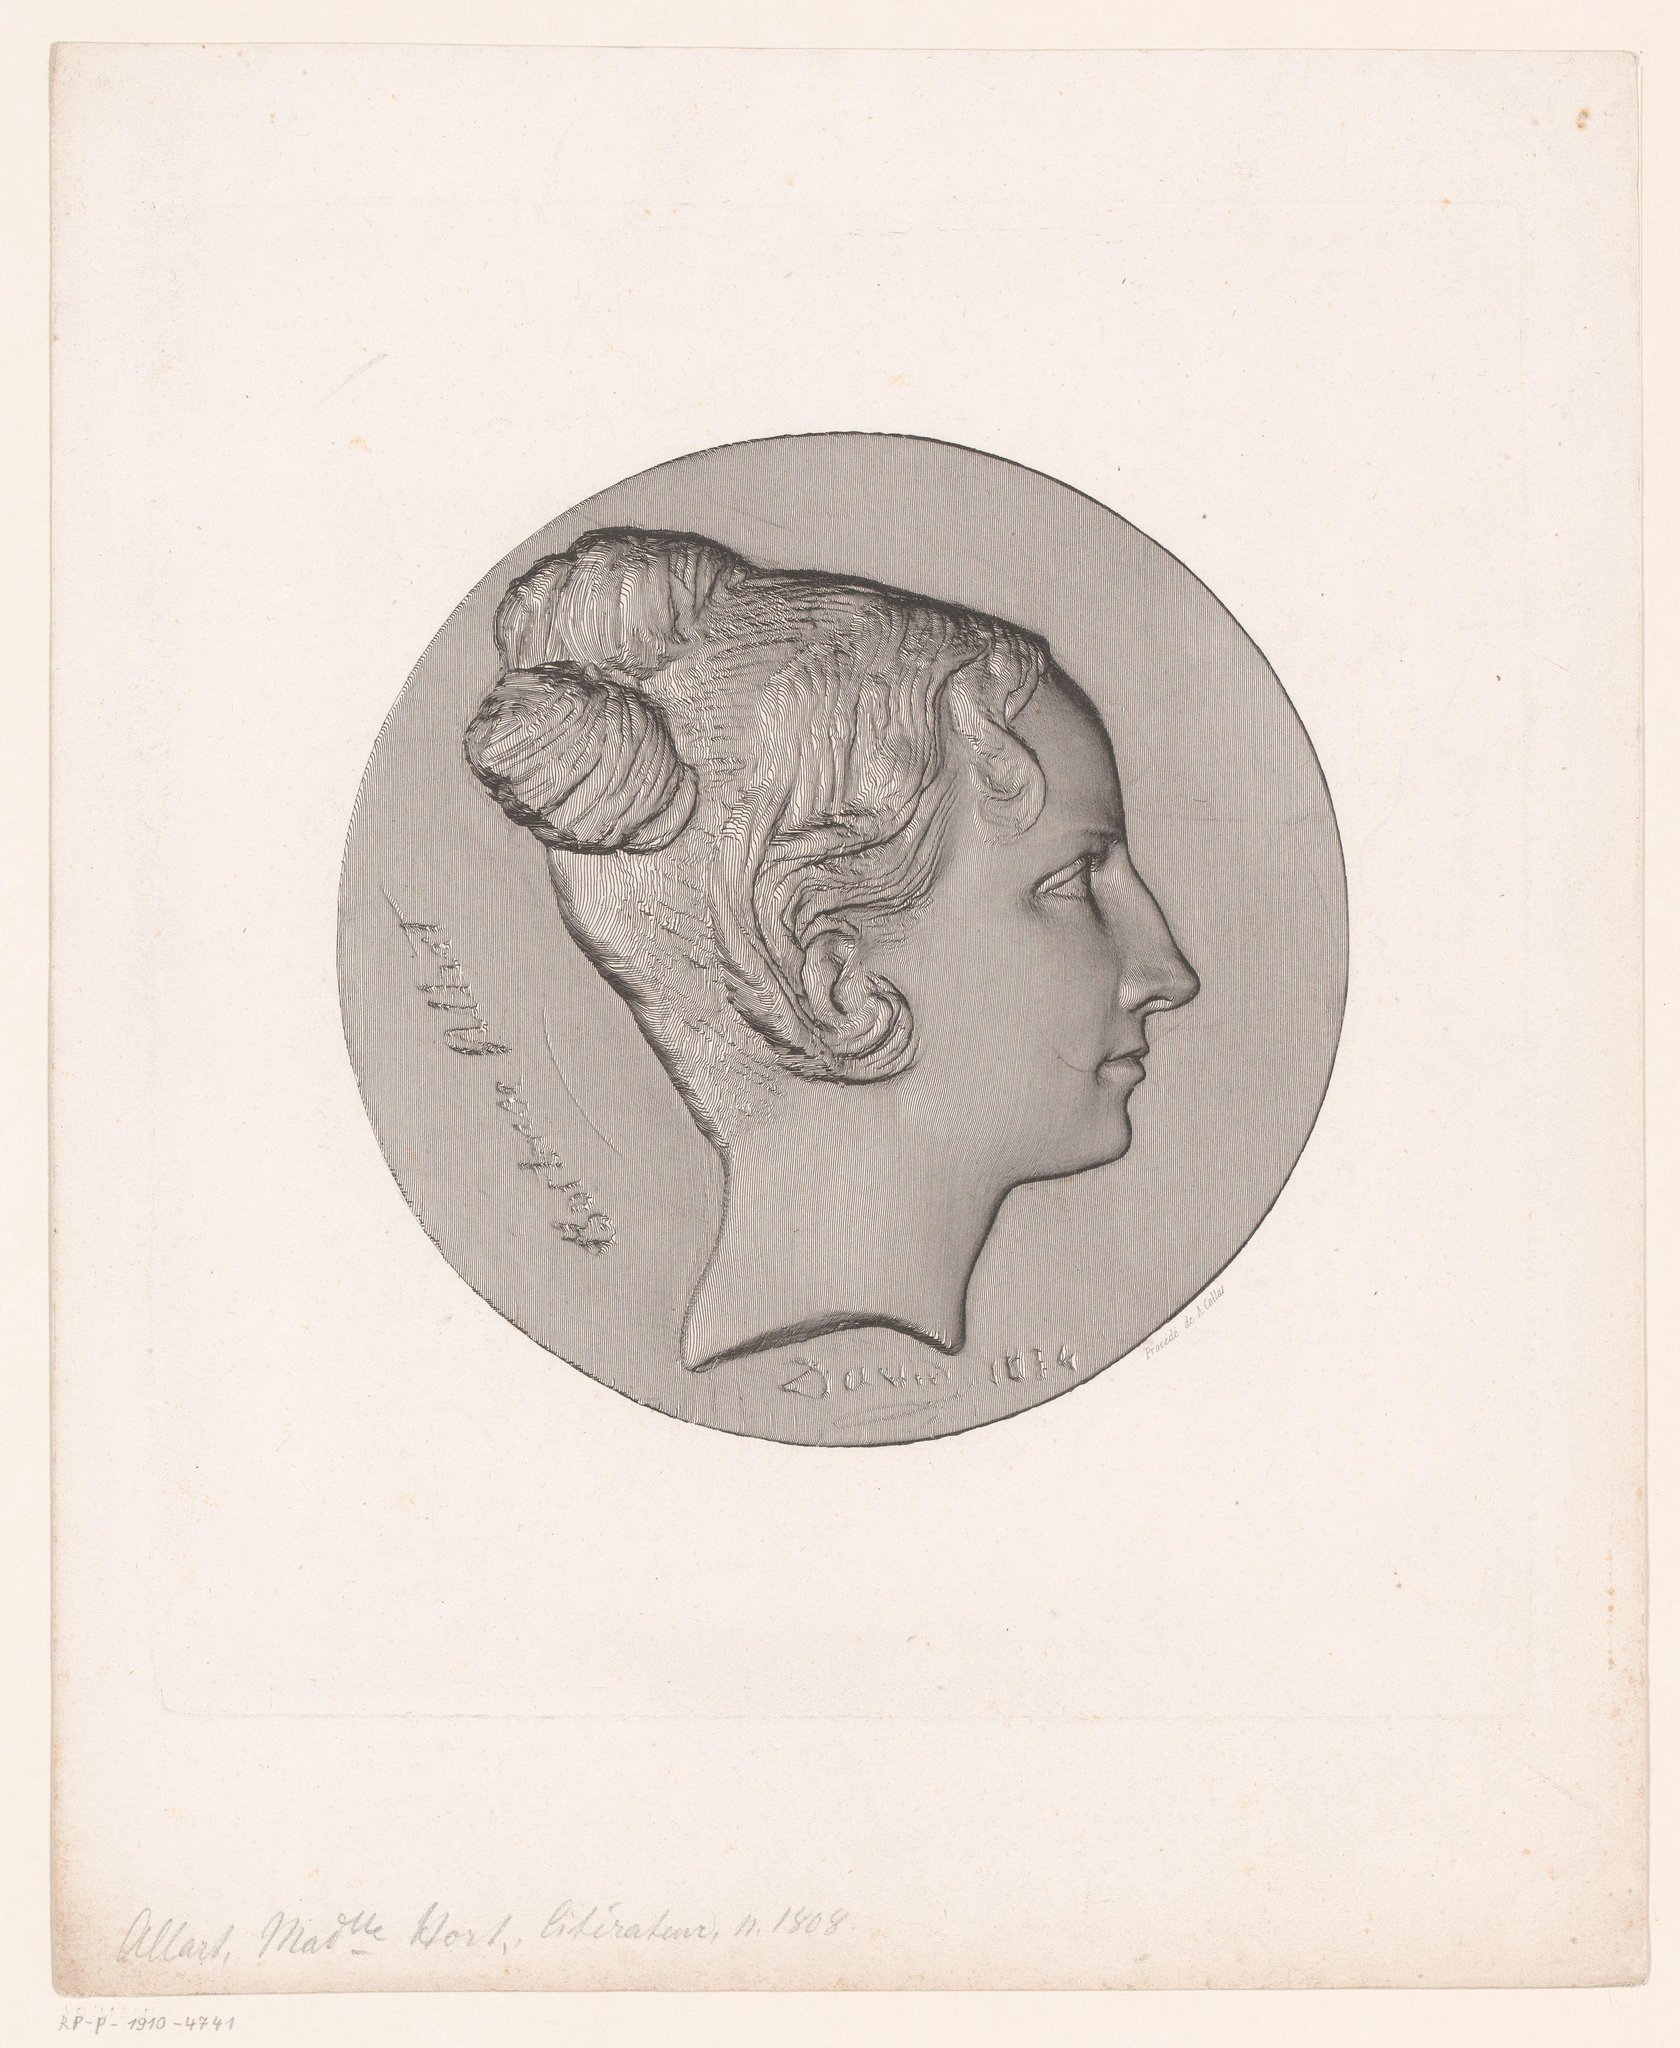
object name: print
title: Medaillon met portret van Barbra Allart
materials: paper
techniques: relief engraving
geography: france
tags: historical persons - bb - woman, ornament ~ medallion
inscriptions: collector's mark: Lugt 2228